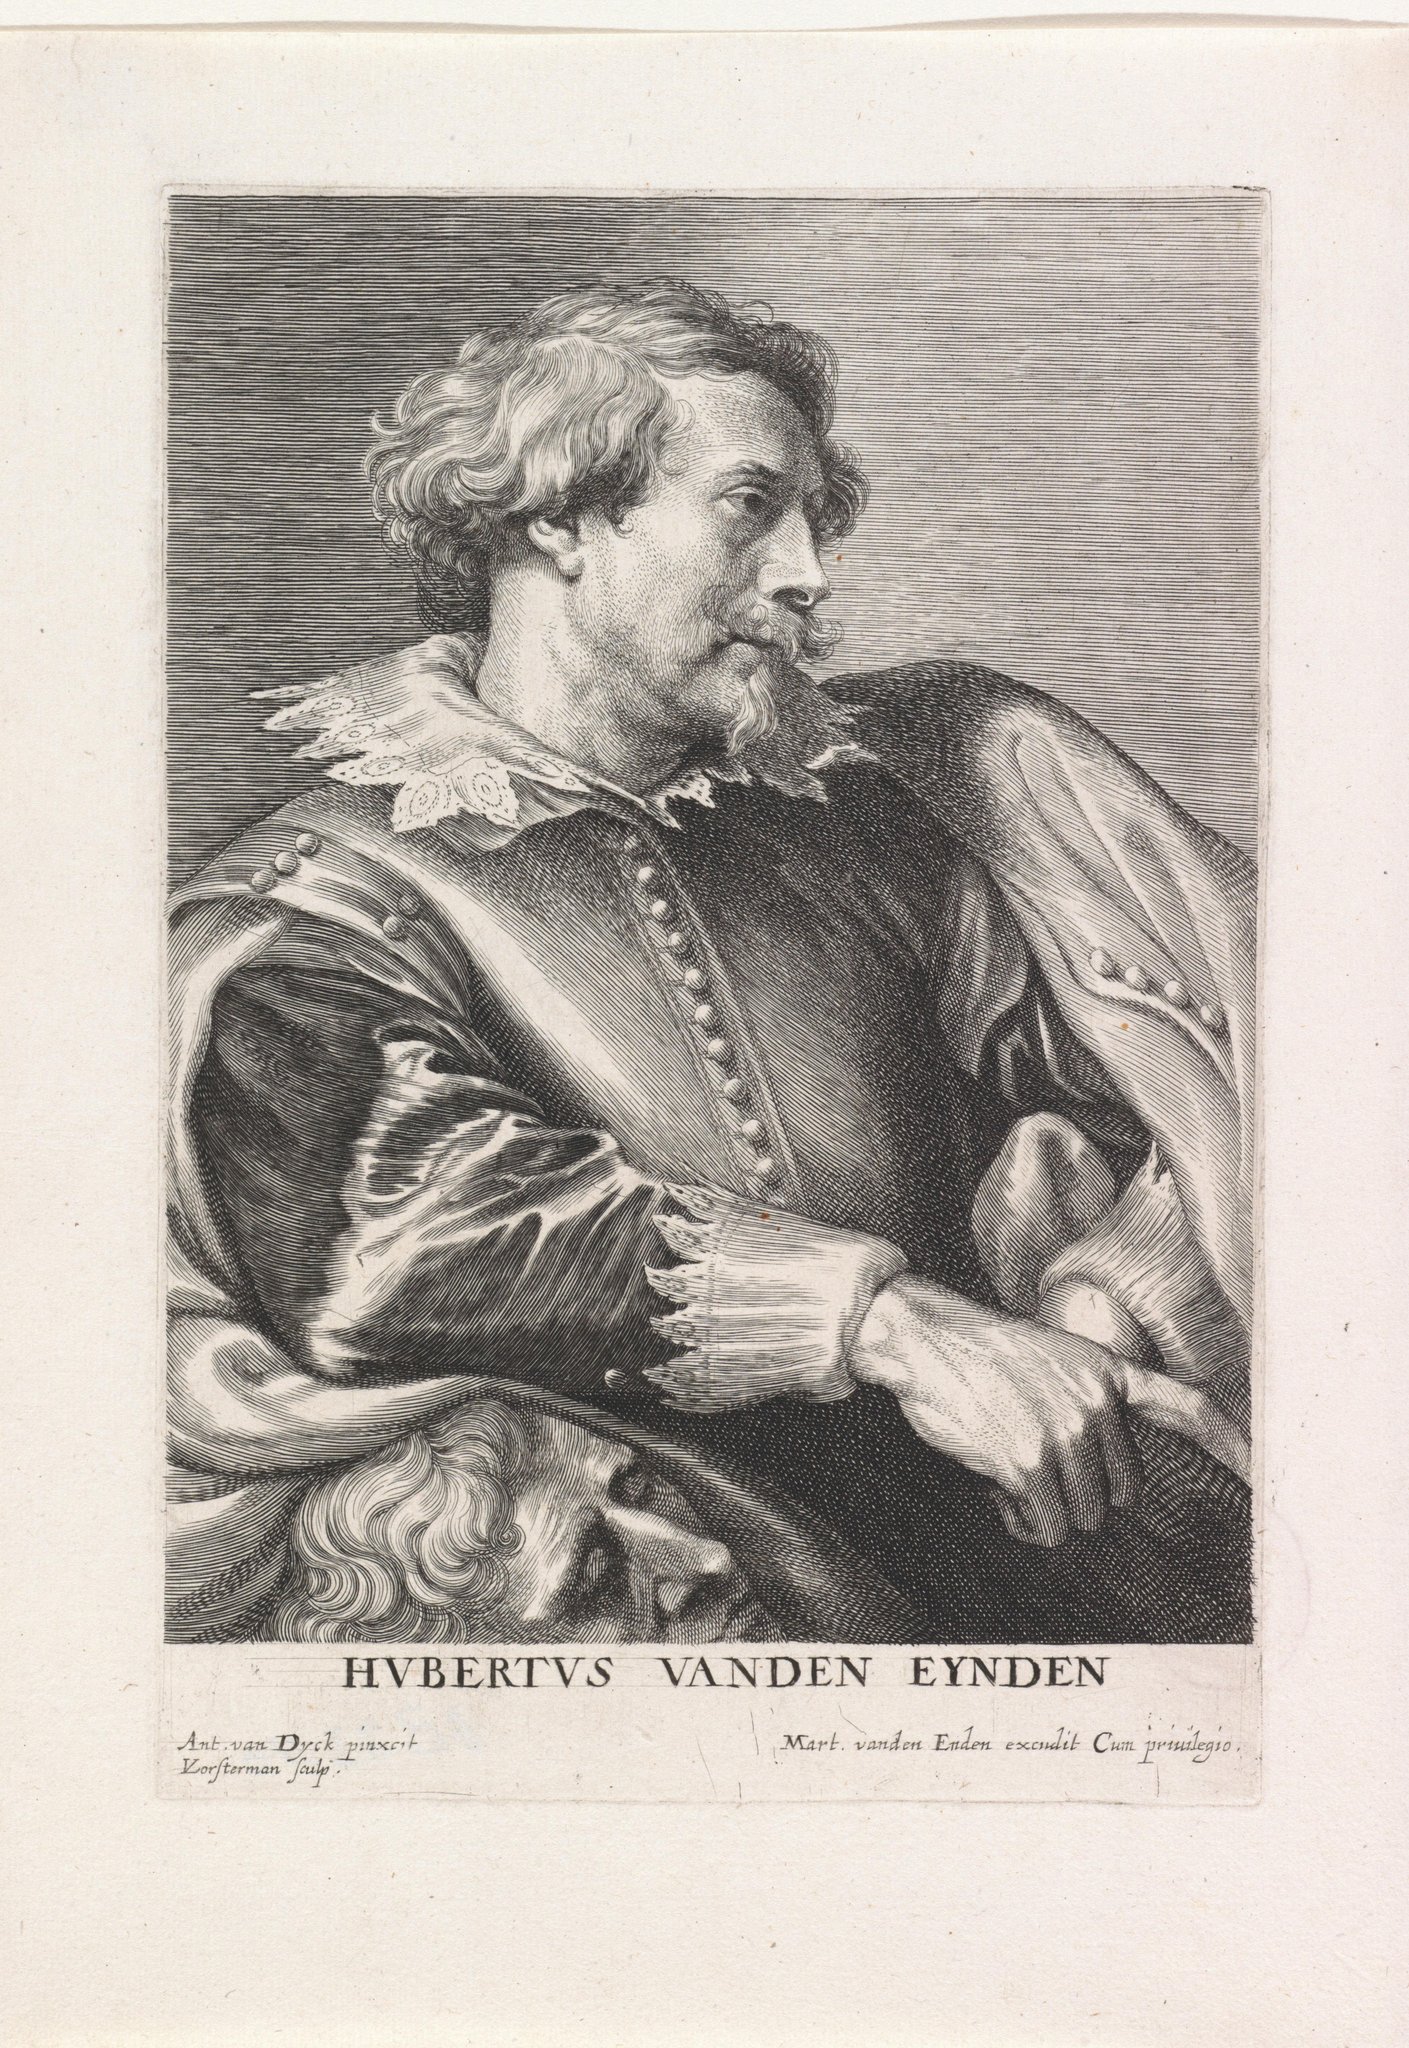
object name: print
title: Iconographie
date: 1630-1646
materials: paper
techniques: engraving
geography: antwerp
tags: antwerp, piece of sculpture, reproduction of a piece of sculpture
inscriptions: collector's mark: Lugt 240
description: Prent gebruikt voor: Icones principum, virorum doctorum, pictorum, chalcographorum, statuariorum nec non amatorum pictoriae artis numero centum ab Ant. van Dyck ad vivum expressae ejusque sumptibus aeri incisae. Antwerpen: Gillis Hendricx, [1645-1646].